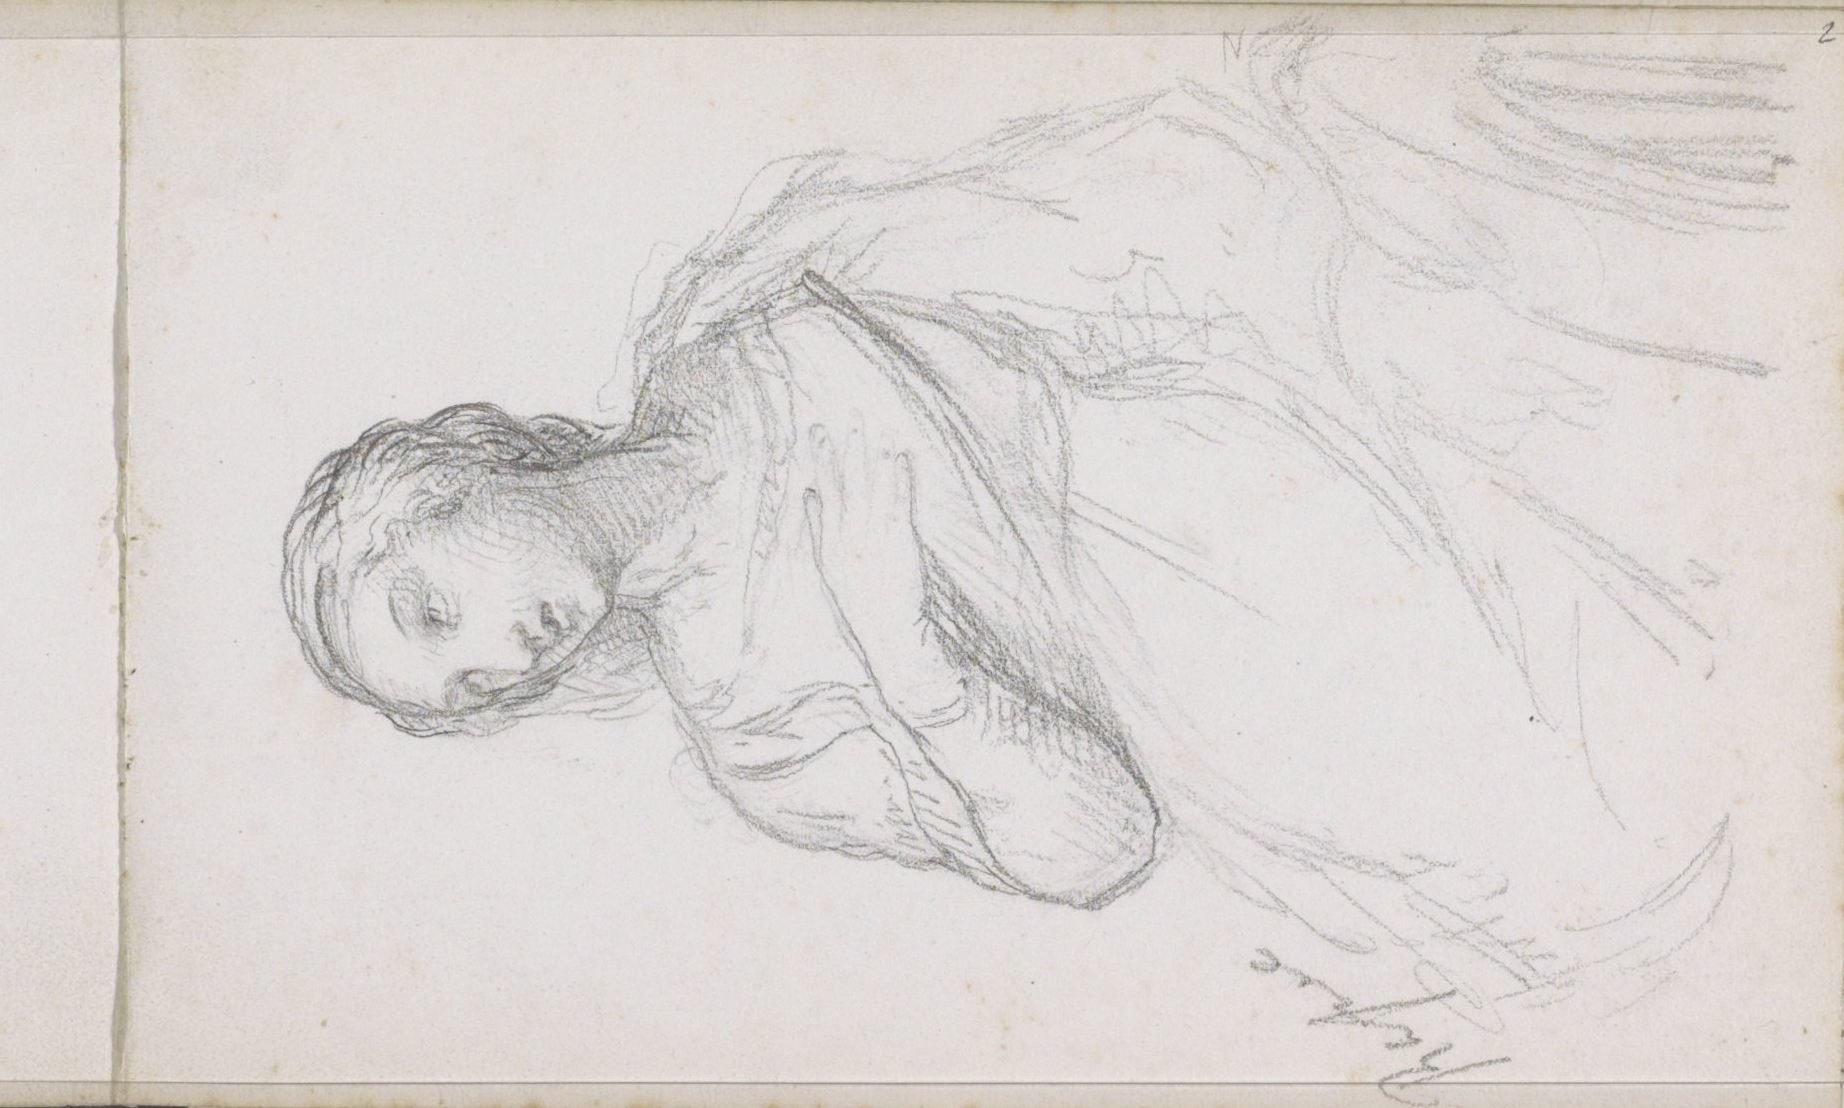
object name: sketchbook leaf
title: Kopie naar Rafaëls 'De heilige Catharina van Alexandrië'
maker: maria vos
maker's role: draughtsman, painter, print maker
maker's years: 1824-1906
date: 1811-1867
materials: paper, pencil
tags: the virgin martyr catherine of alexandria; possible attributes: book, crown, emperor maxentius, palm-branch, ring, sword, wheel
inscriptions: annotation: ‘Raphael’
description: Blad 2 recto uit een schetsboek met 40 bladen.